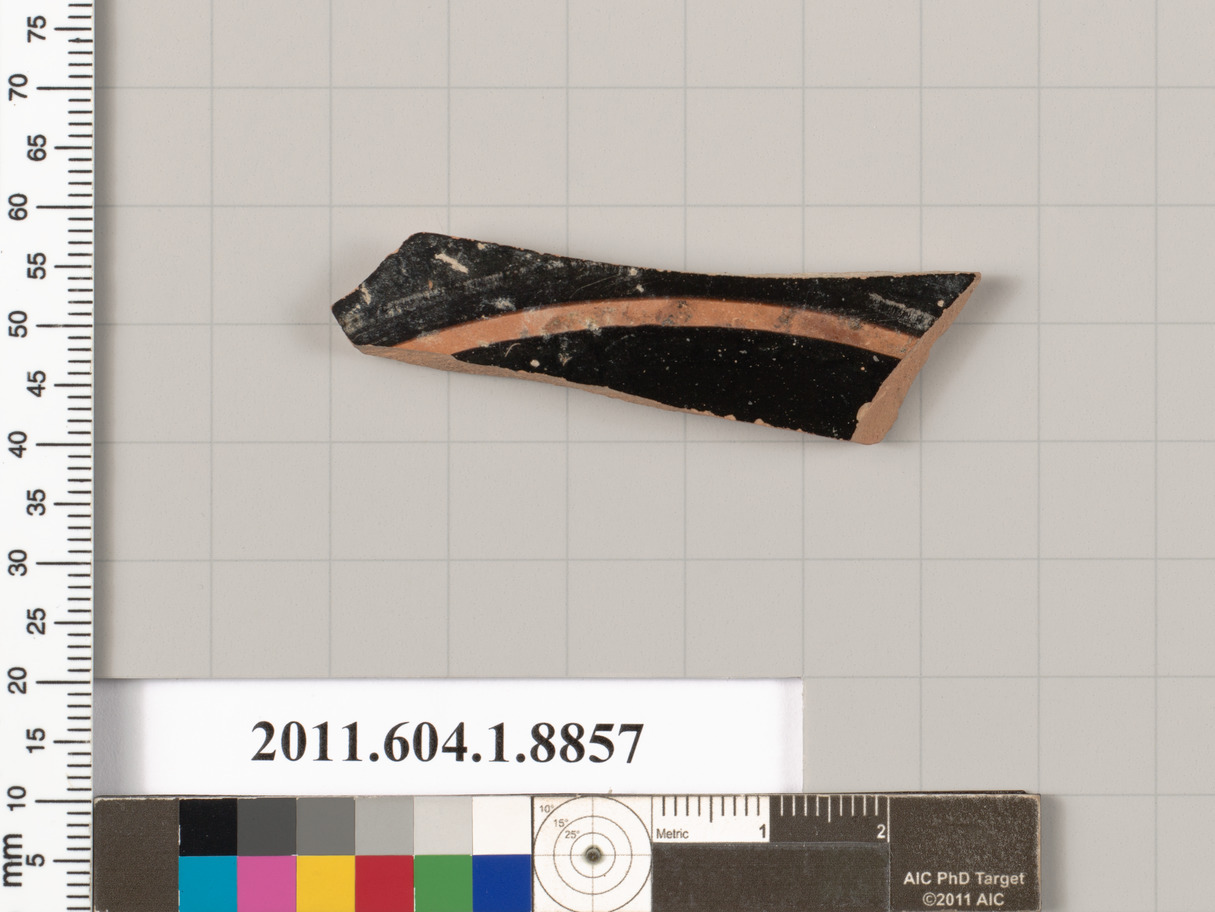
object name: kylix fragment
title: Terracotta fragment of a kylix (drinking cup)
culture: greek, attic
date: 475-451 BCE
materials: terracotta